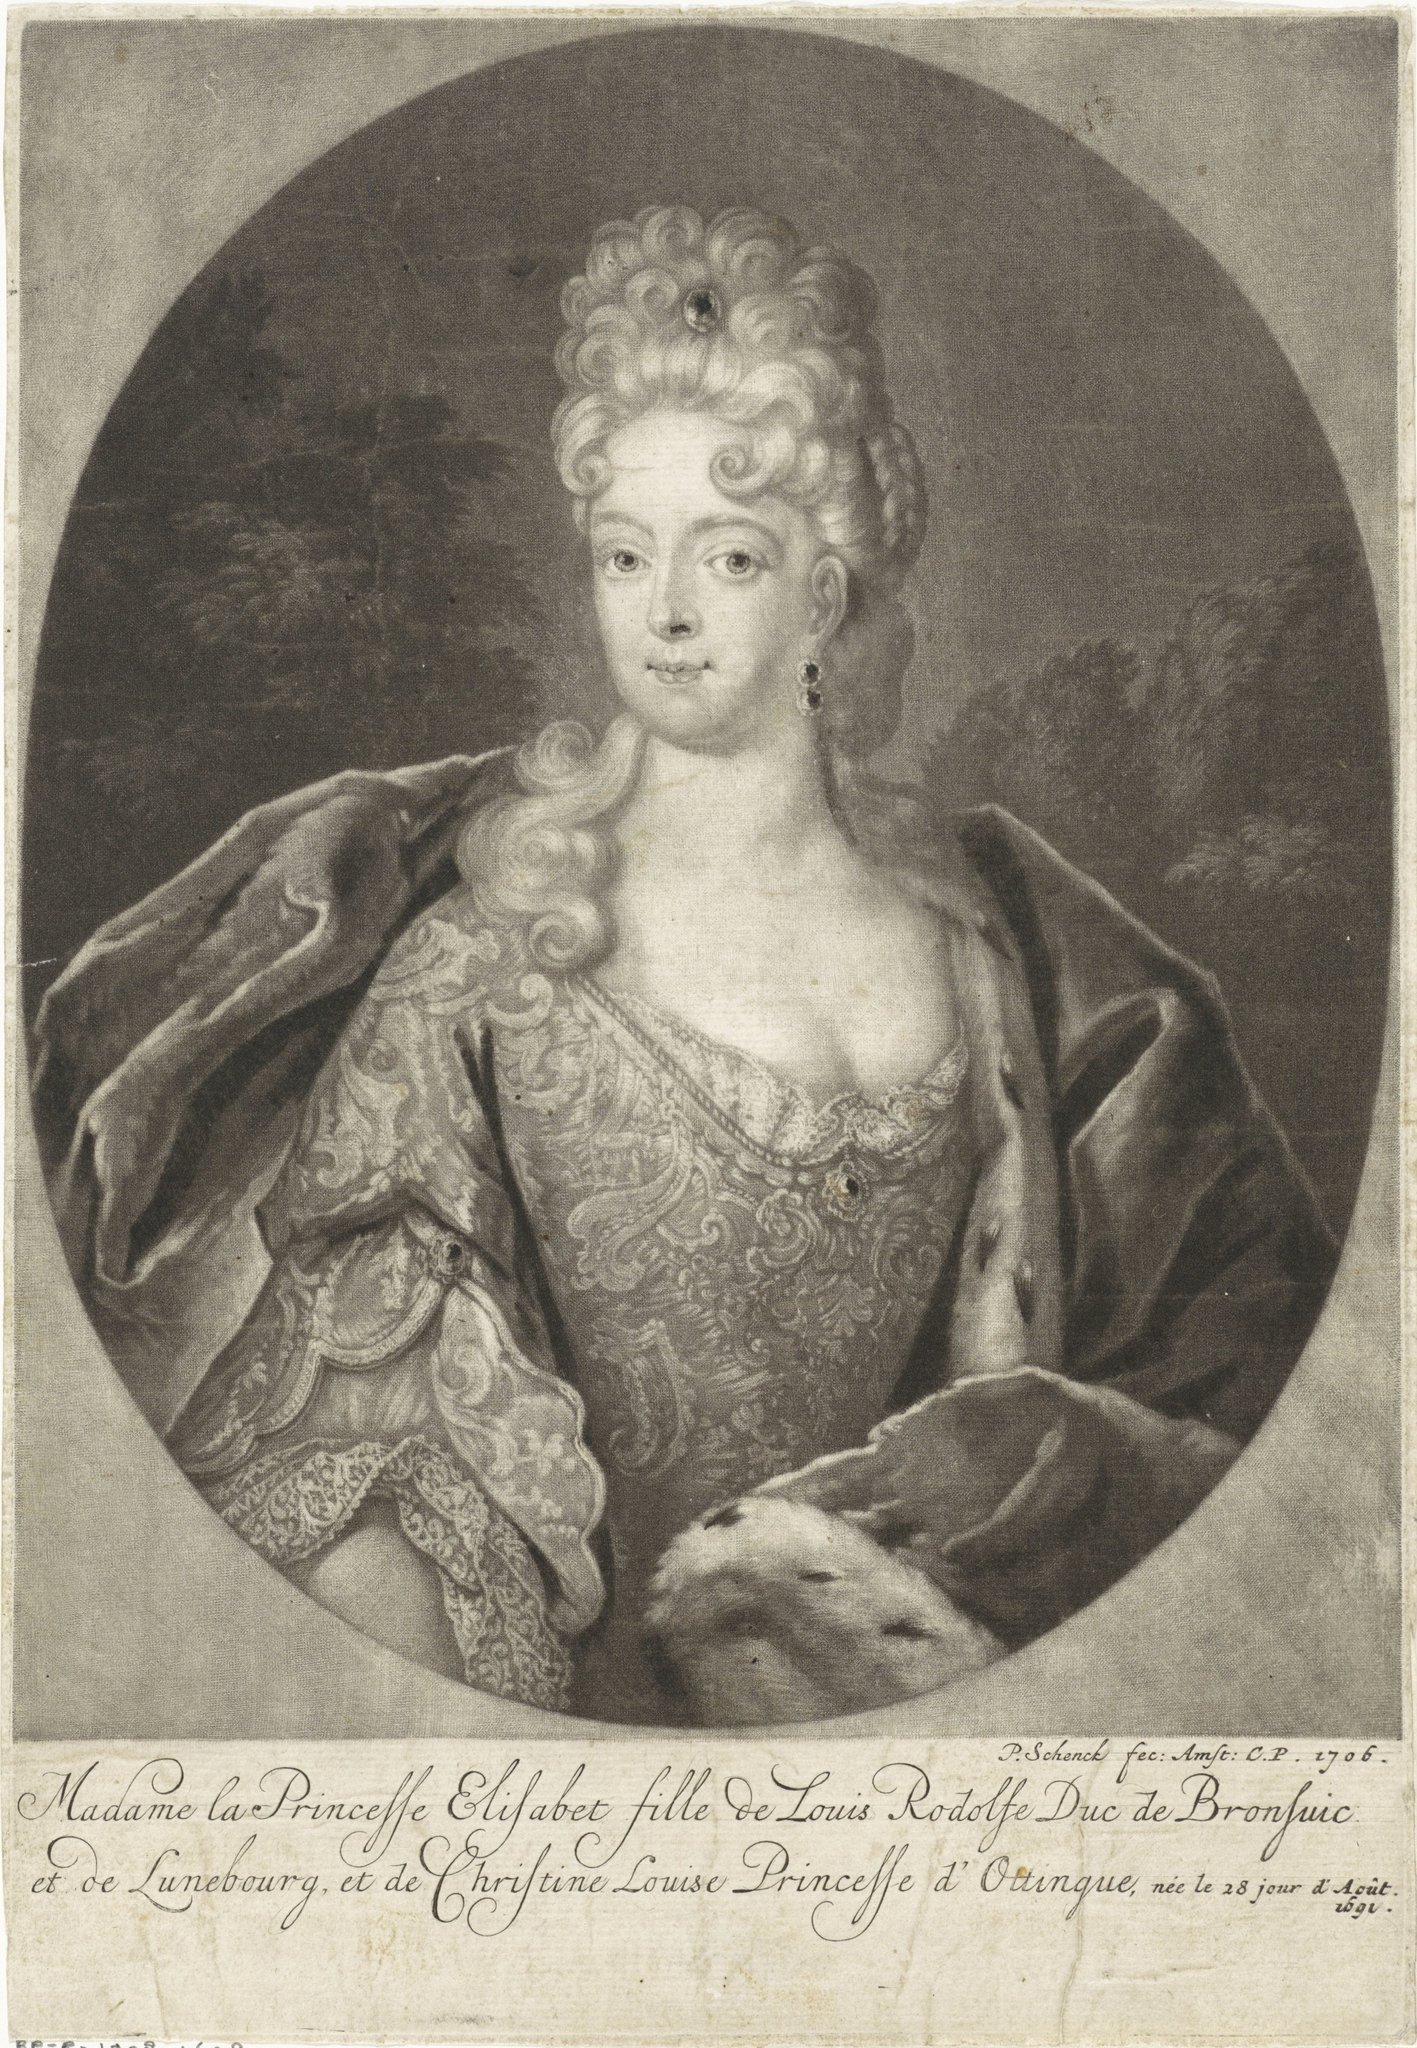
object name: print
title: Portret van Elisabeth Christine van Brunswijk-Wolfenbüttel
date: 1706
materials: paper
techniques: engraving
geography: amsterdam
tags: keizerin, elisabeth christina (keizerin van oostenrijk)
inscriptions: collector's mark: Lugt 2228